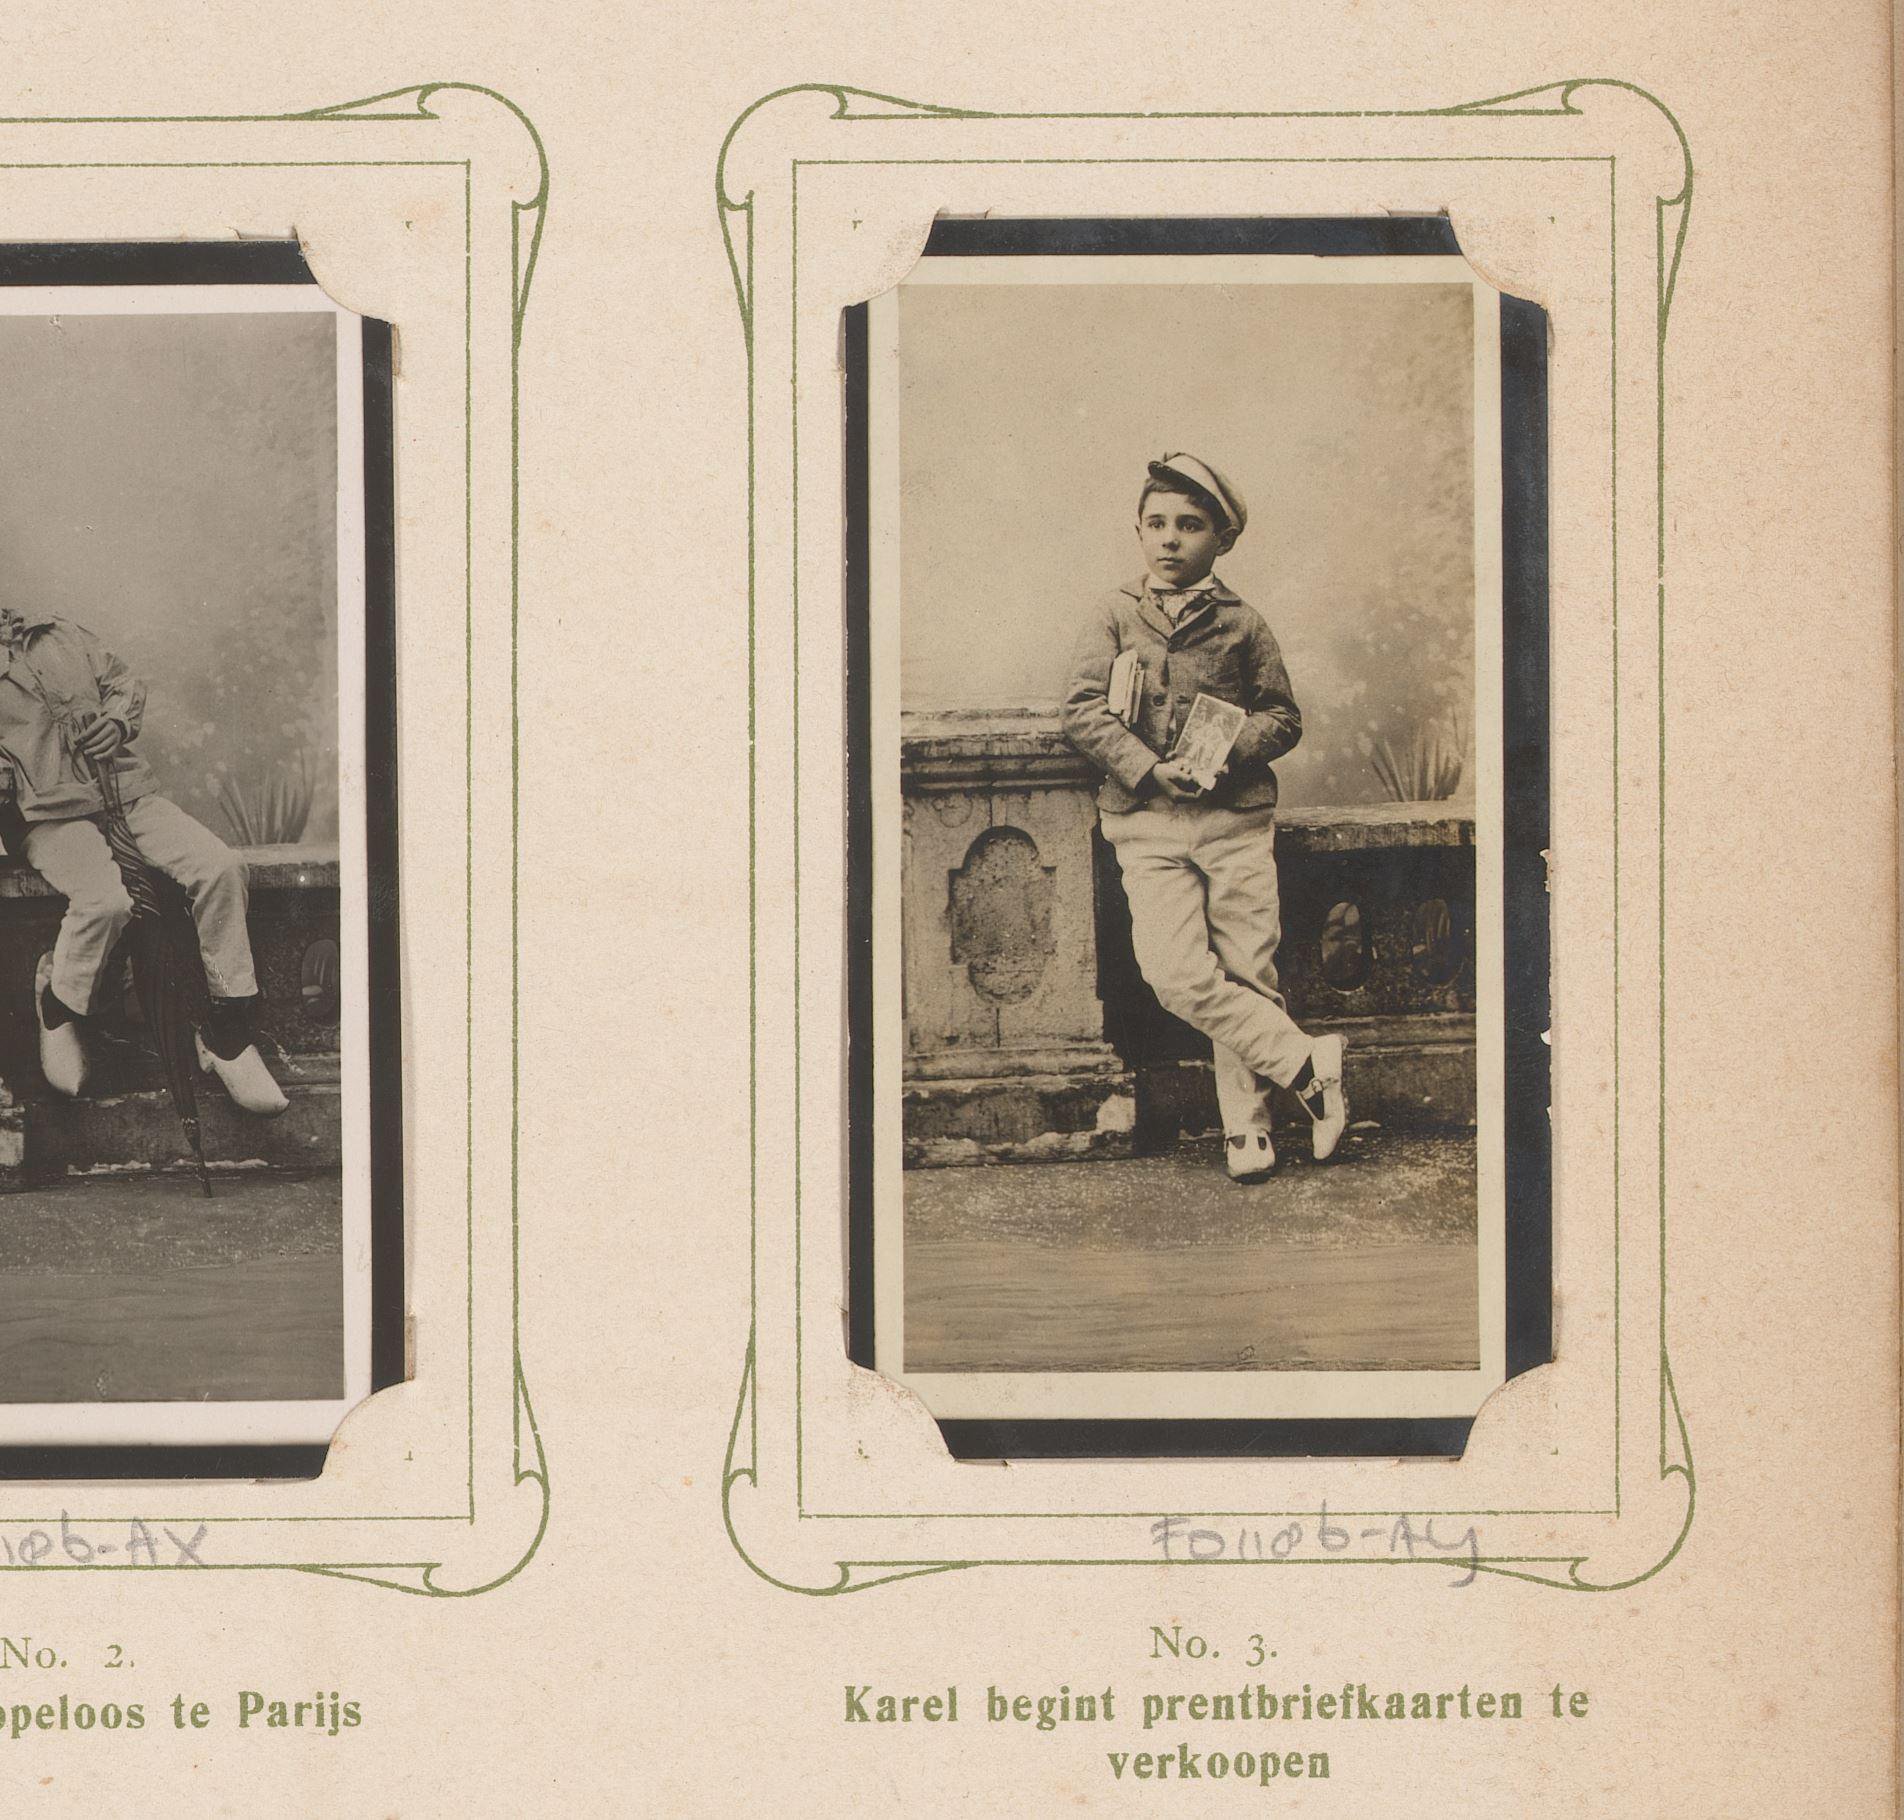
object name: photograph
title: Jongen verkoopt prentbriefkaarten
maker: Anonymous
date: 1904-1905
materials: photographic support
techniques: gelatin silver print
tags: boy (child between toddler and youth), merchant, salesman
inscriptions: inscription: ‘No. 3./ Karel begint prentbriefkaarten te verkoopen’